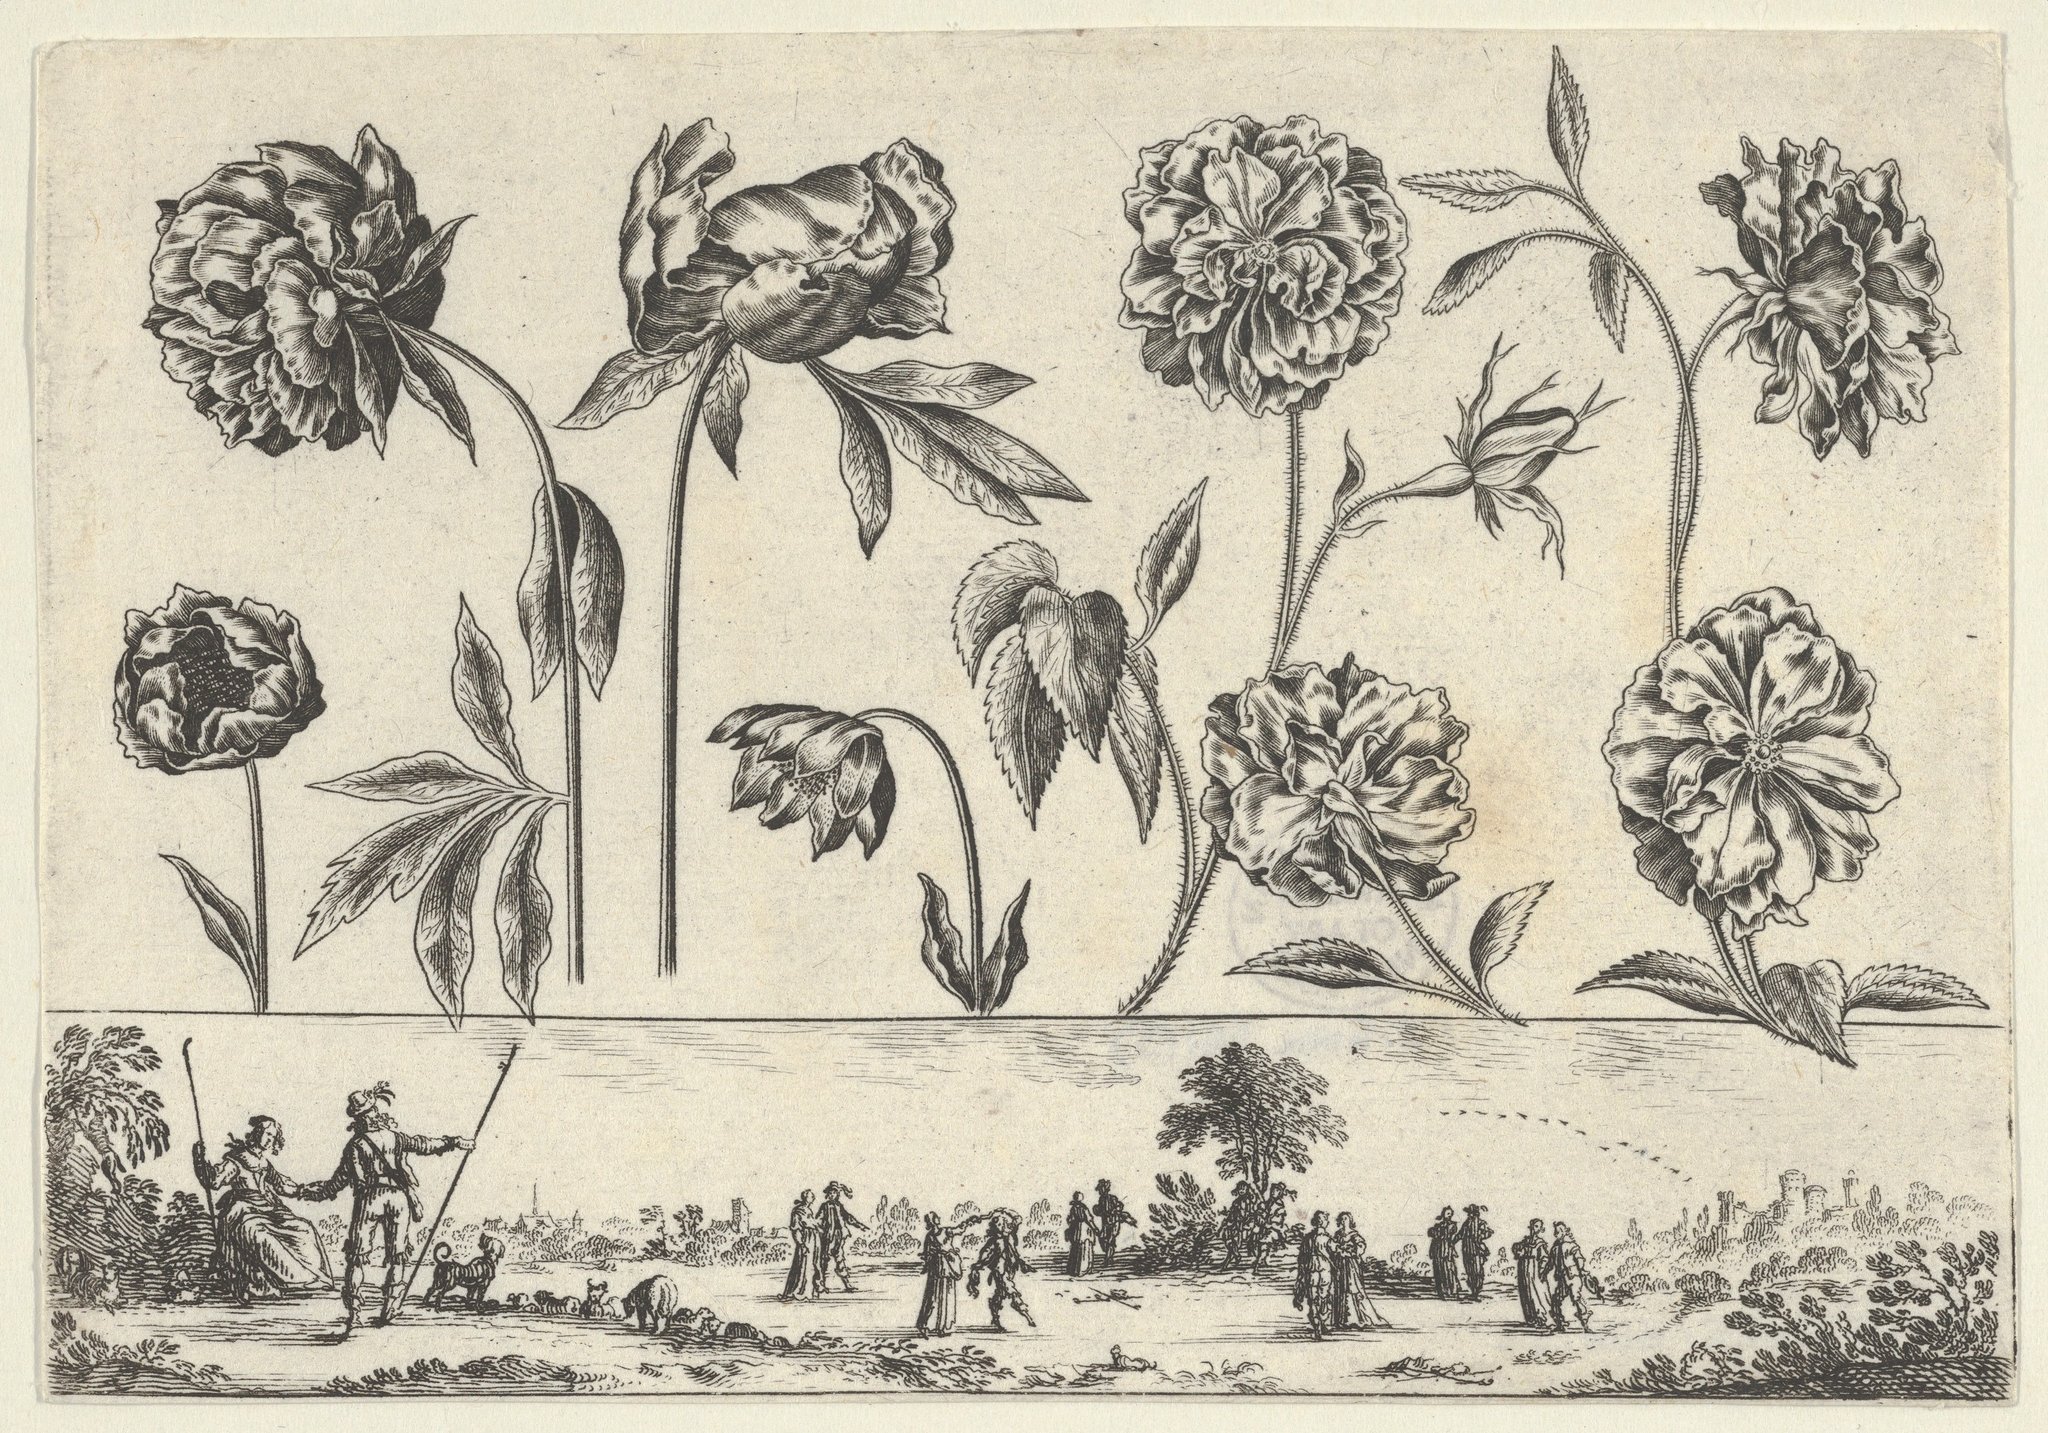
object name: print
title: Horizontal Panel with a Row of Flowers Above a Frieze with Figures in a Landscape, from "Livre Nouveau de Fleurs Tres-Util"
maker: nicolas cochin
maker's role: artist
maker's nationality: french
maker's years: 1610-1686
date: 1645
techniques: engraving, etching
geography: france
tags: flowers